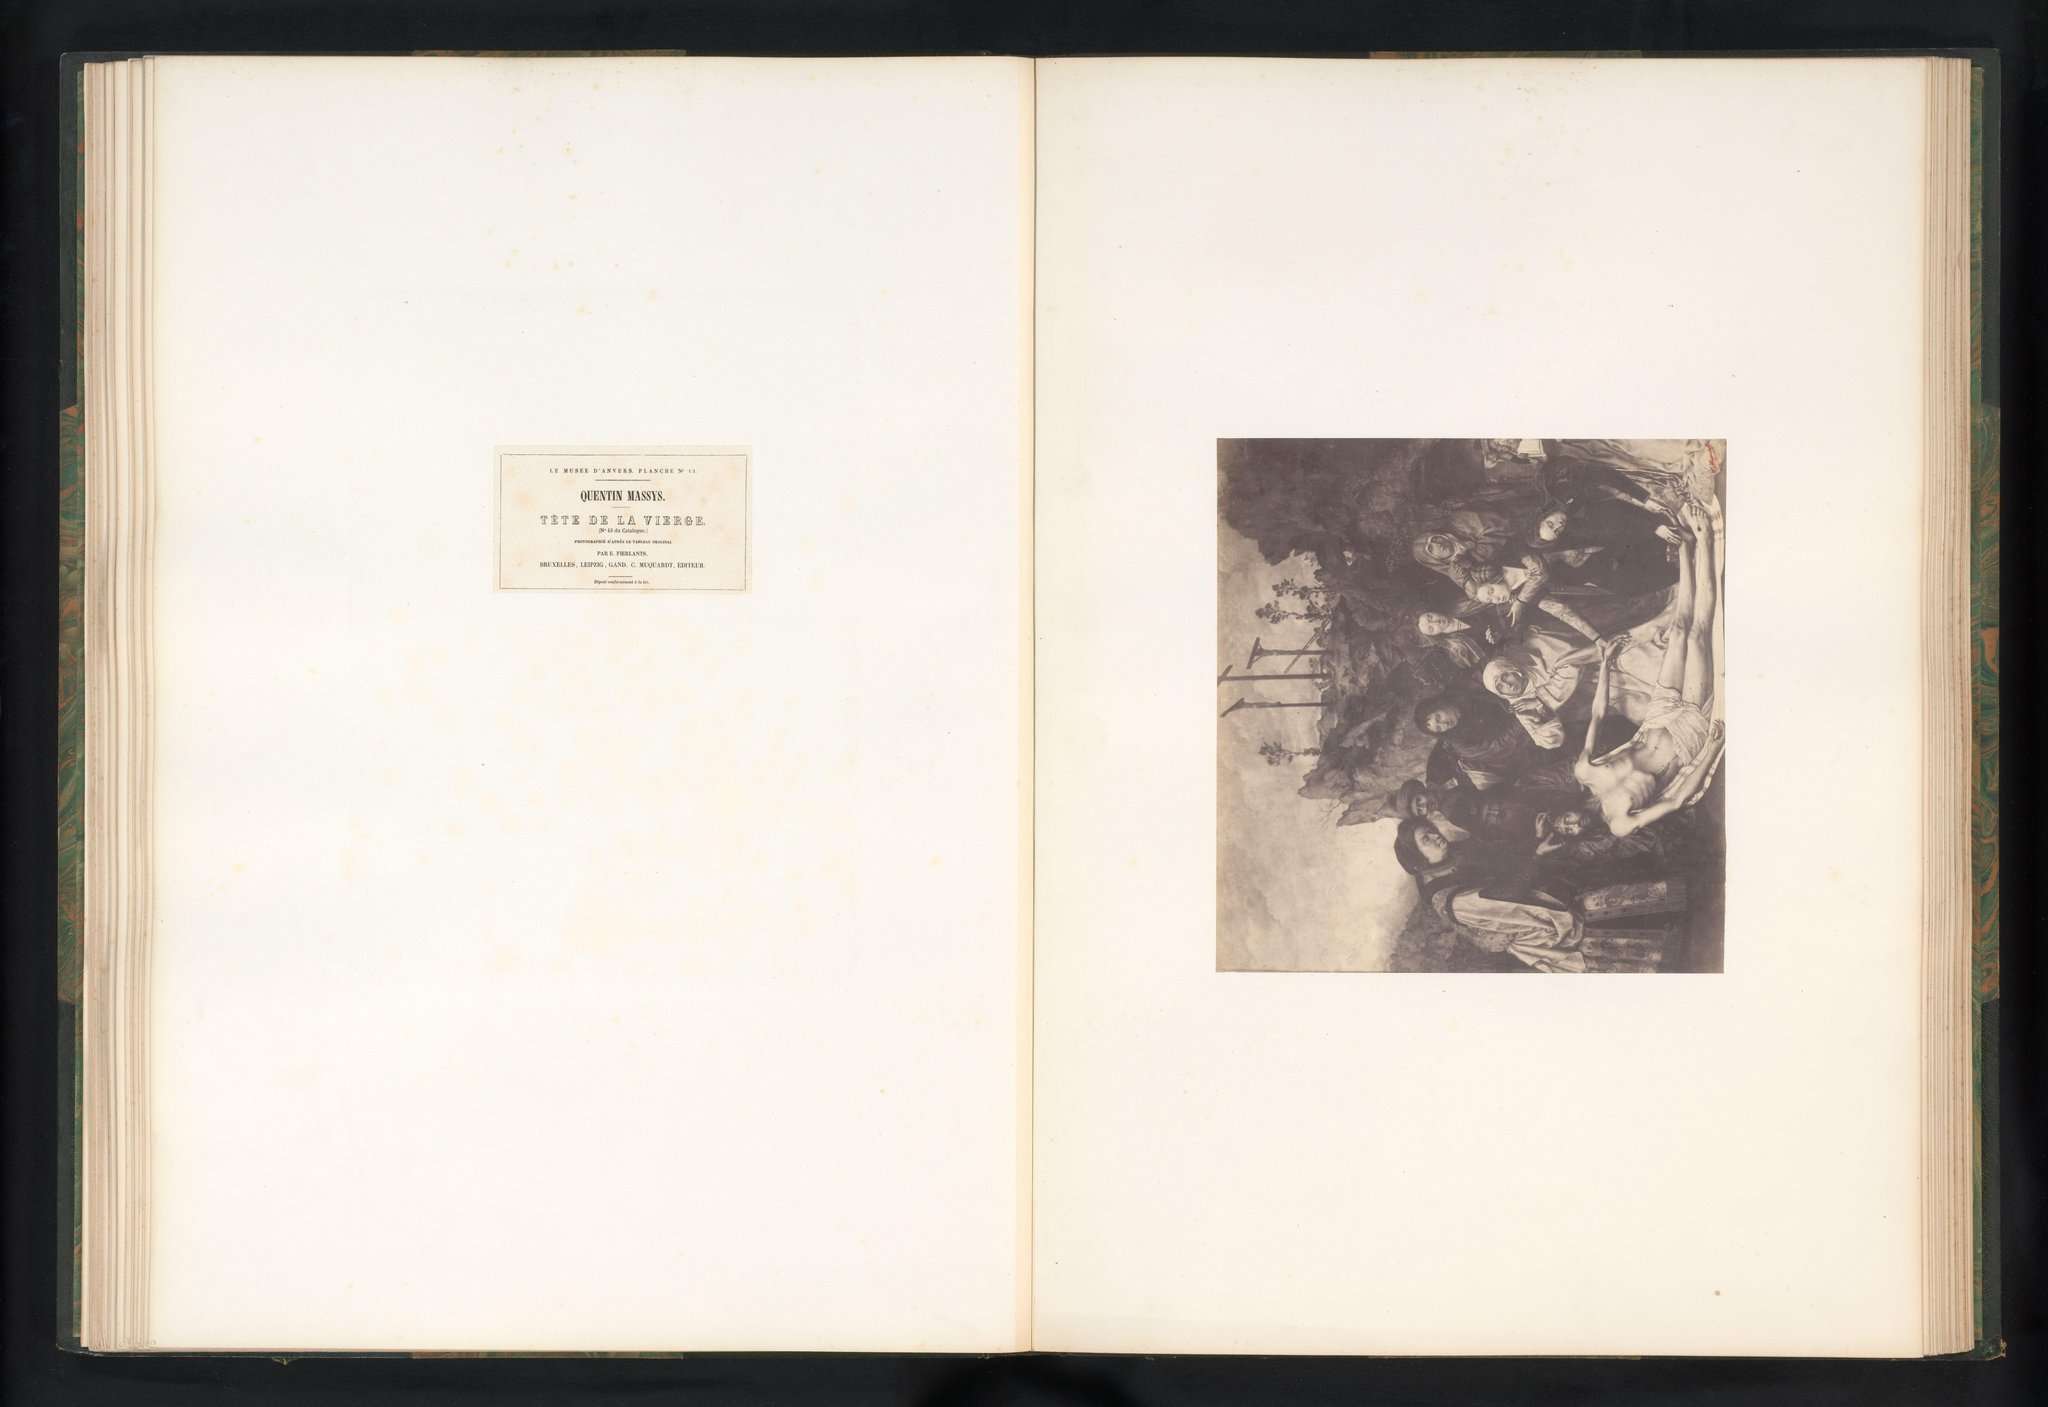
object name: reproduction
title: Fotoreproductie van de Bewening van Christus door Quinten Massijs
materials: photographic support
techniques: albumen print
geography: brussels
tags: lamentation over the dead christ by his relatives and friends (christ usually without crown of thorns)